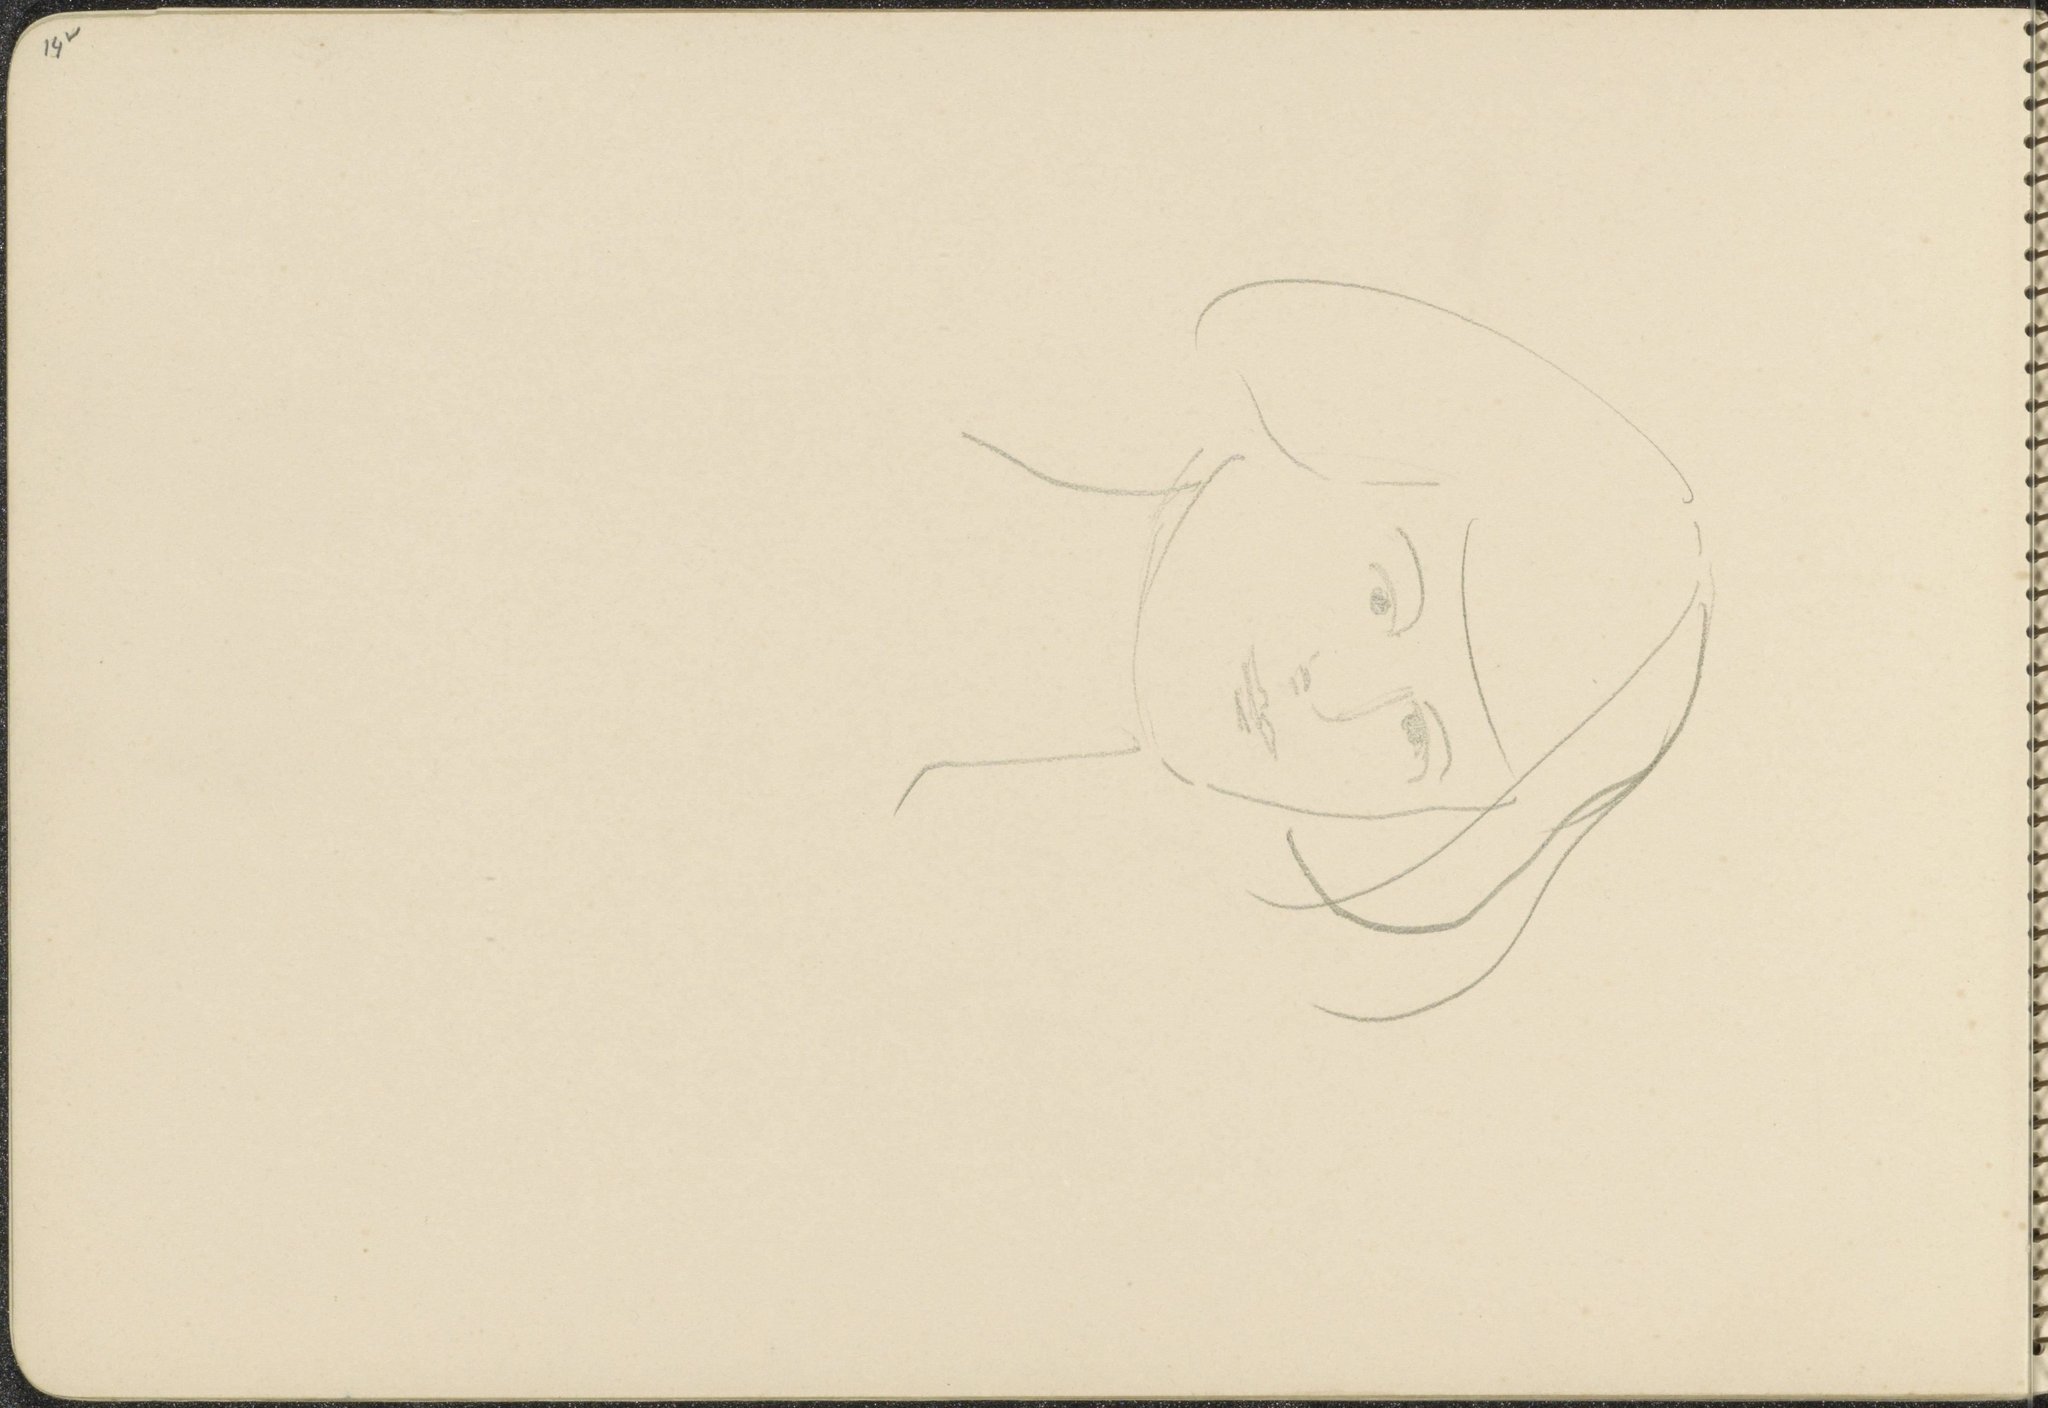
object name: sketchbook leaf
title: Kop van een meisje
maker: carel adolph lion cachet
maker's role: draughtsman, print maker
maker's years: 1864-1945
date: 1934-1943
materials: paper, pencil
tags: head (human)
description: Blad 14 verso uit een schetsboek met 19 bladen.